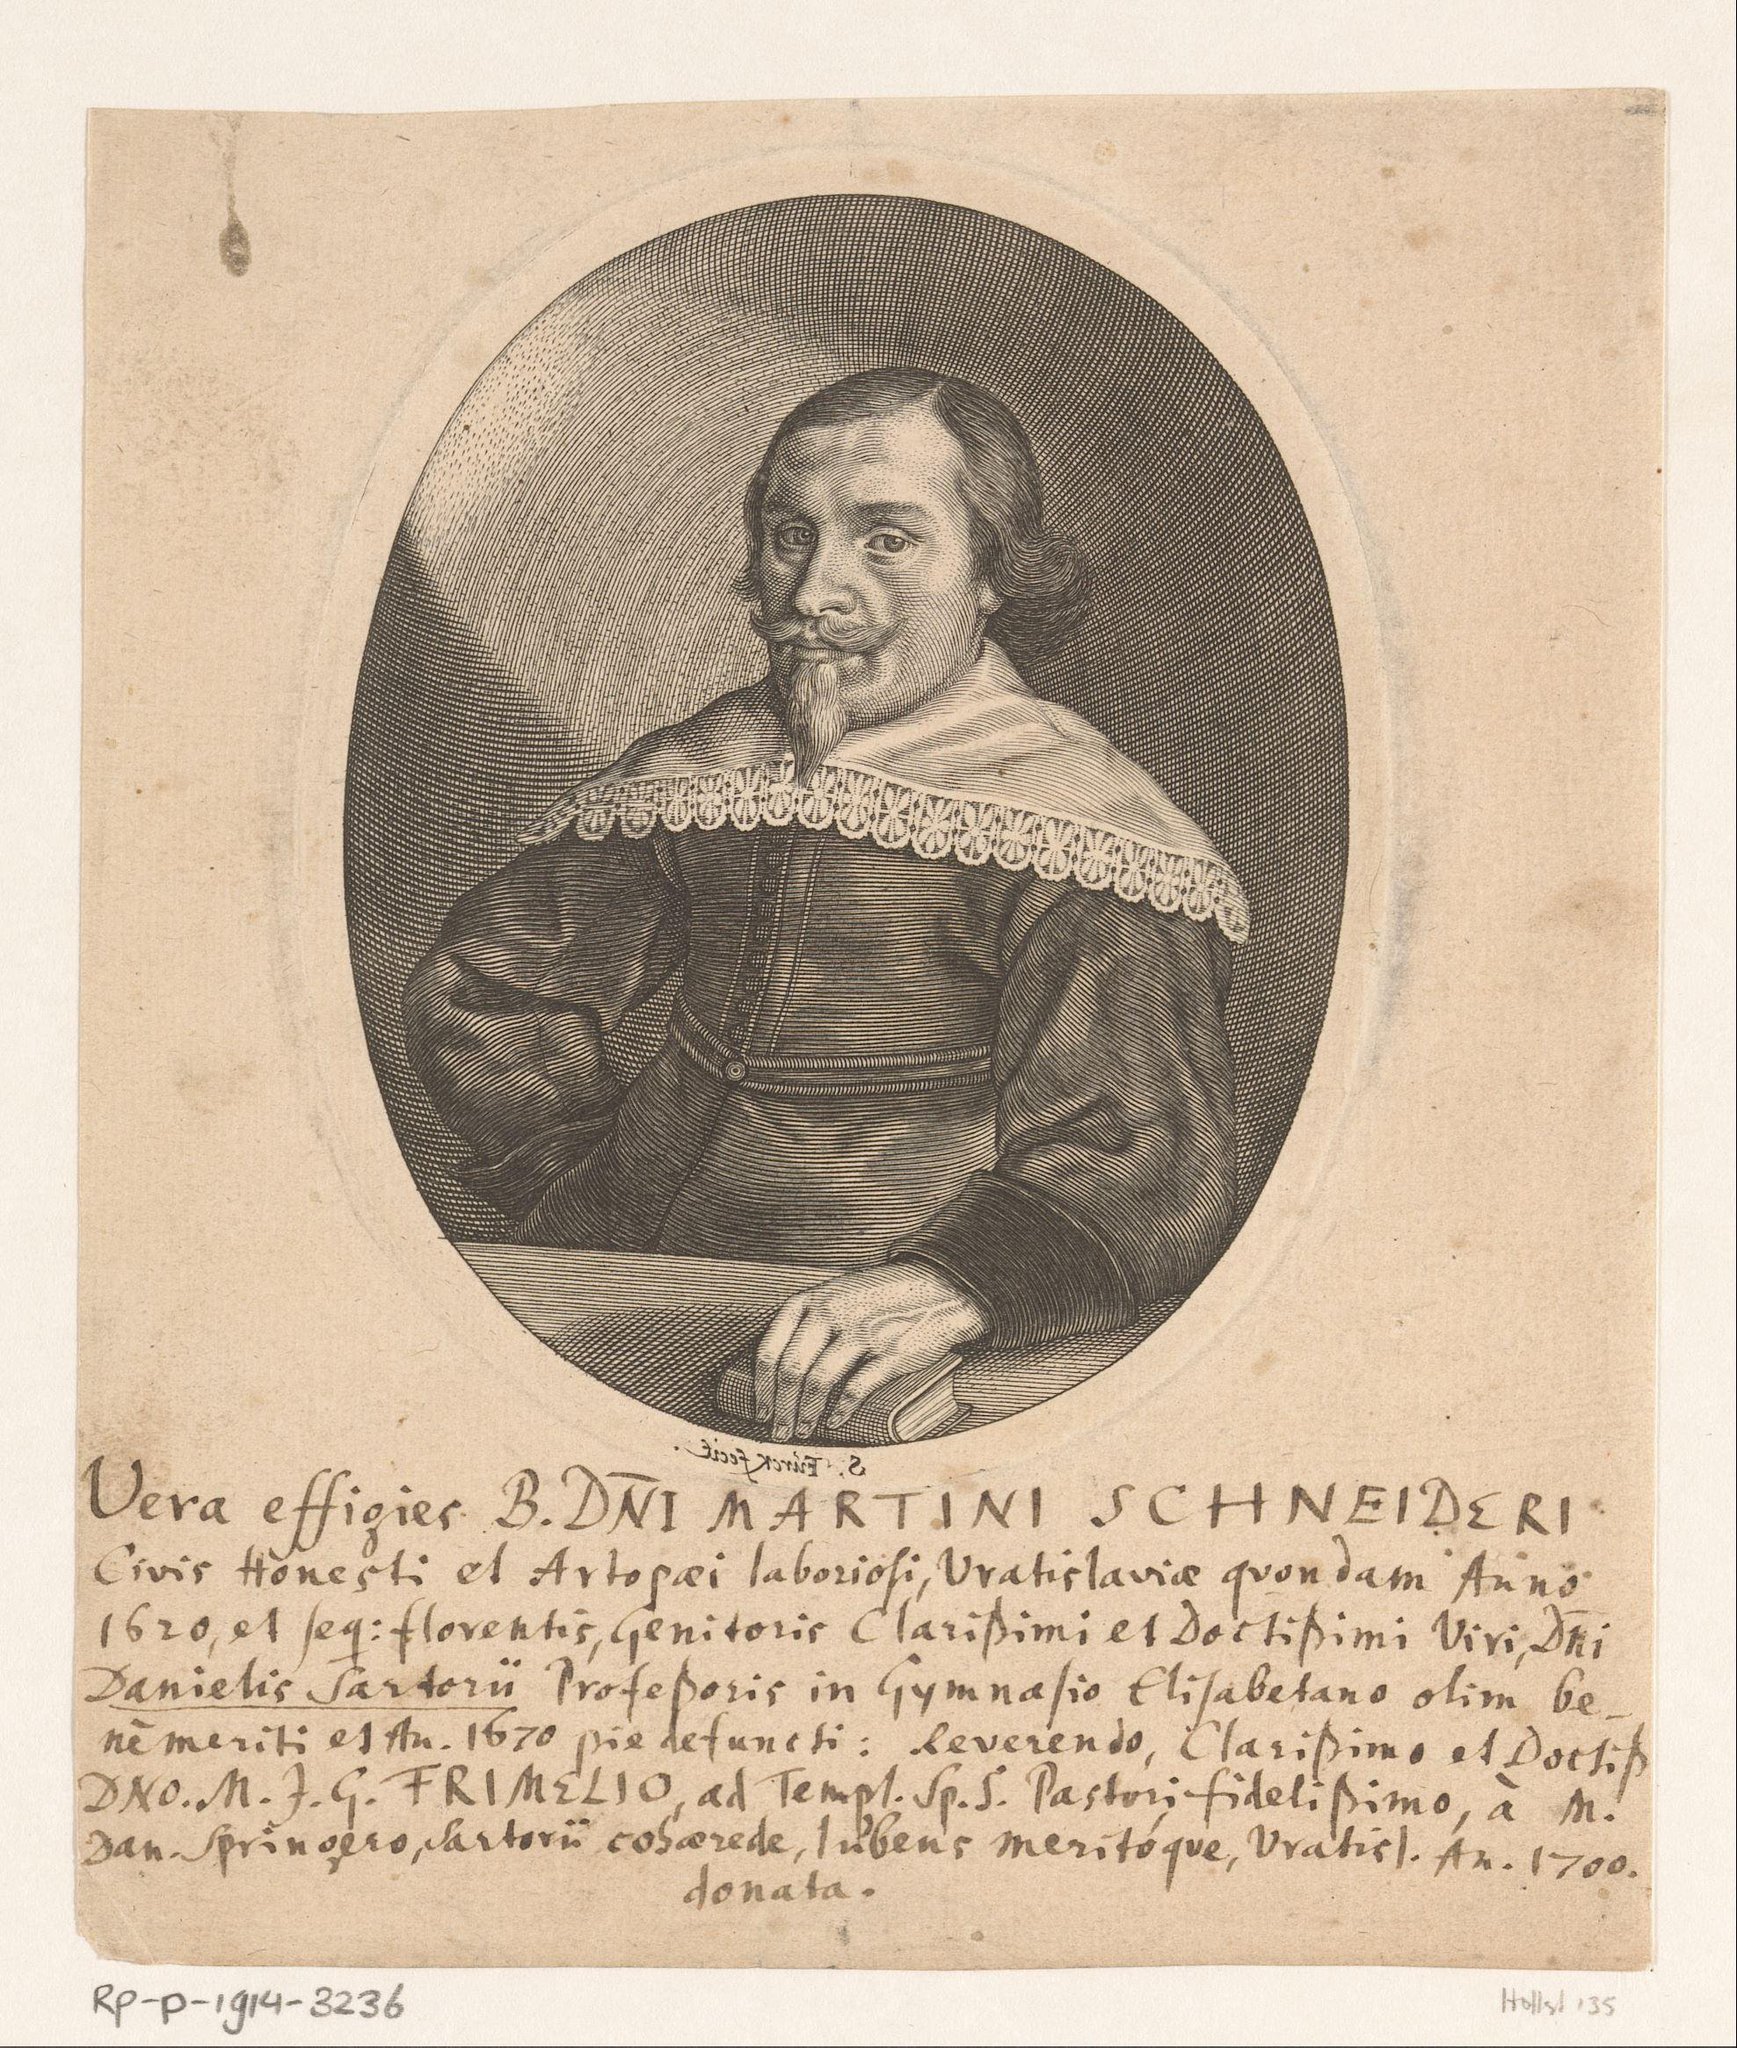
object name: print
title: Portret van Martin Schneider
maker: sebastian furck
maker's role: print maker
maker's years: 1600-1655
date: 1630-1655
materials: paper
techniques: engraving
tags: historical persons, book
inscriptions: inscription, collector's mark: Lugt 2228